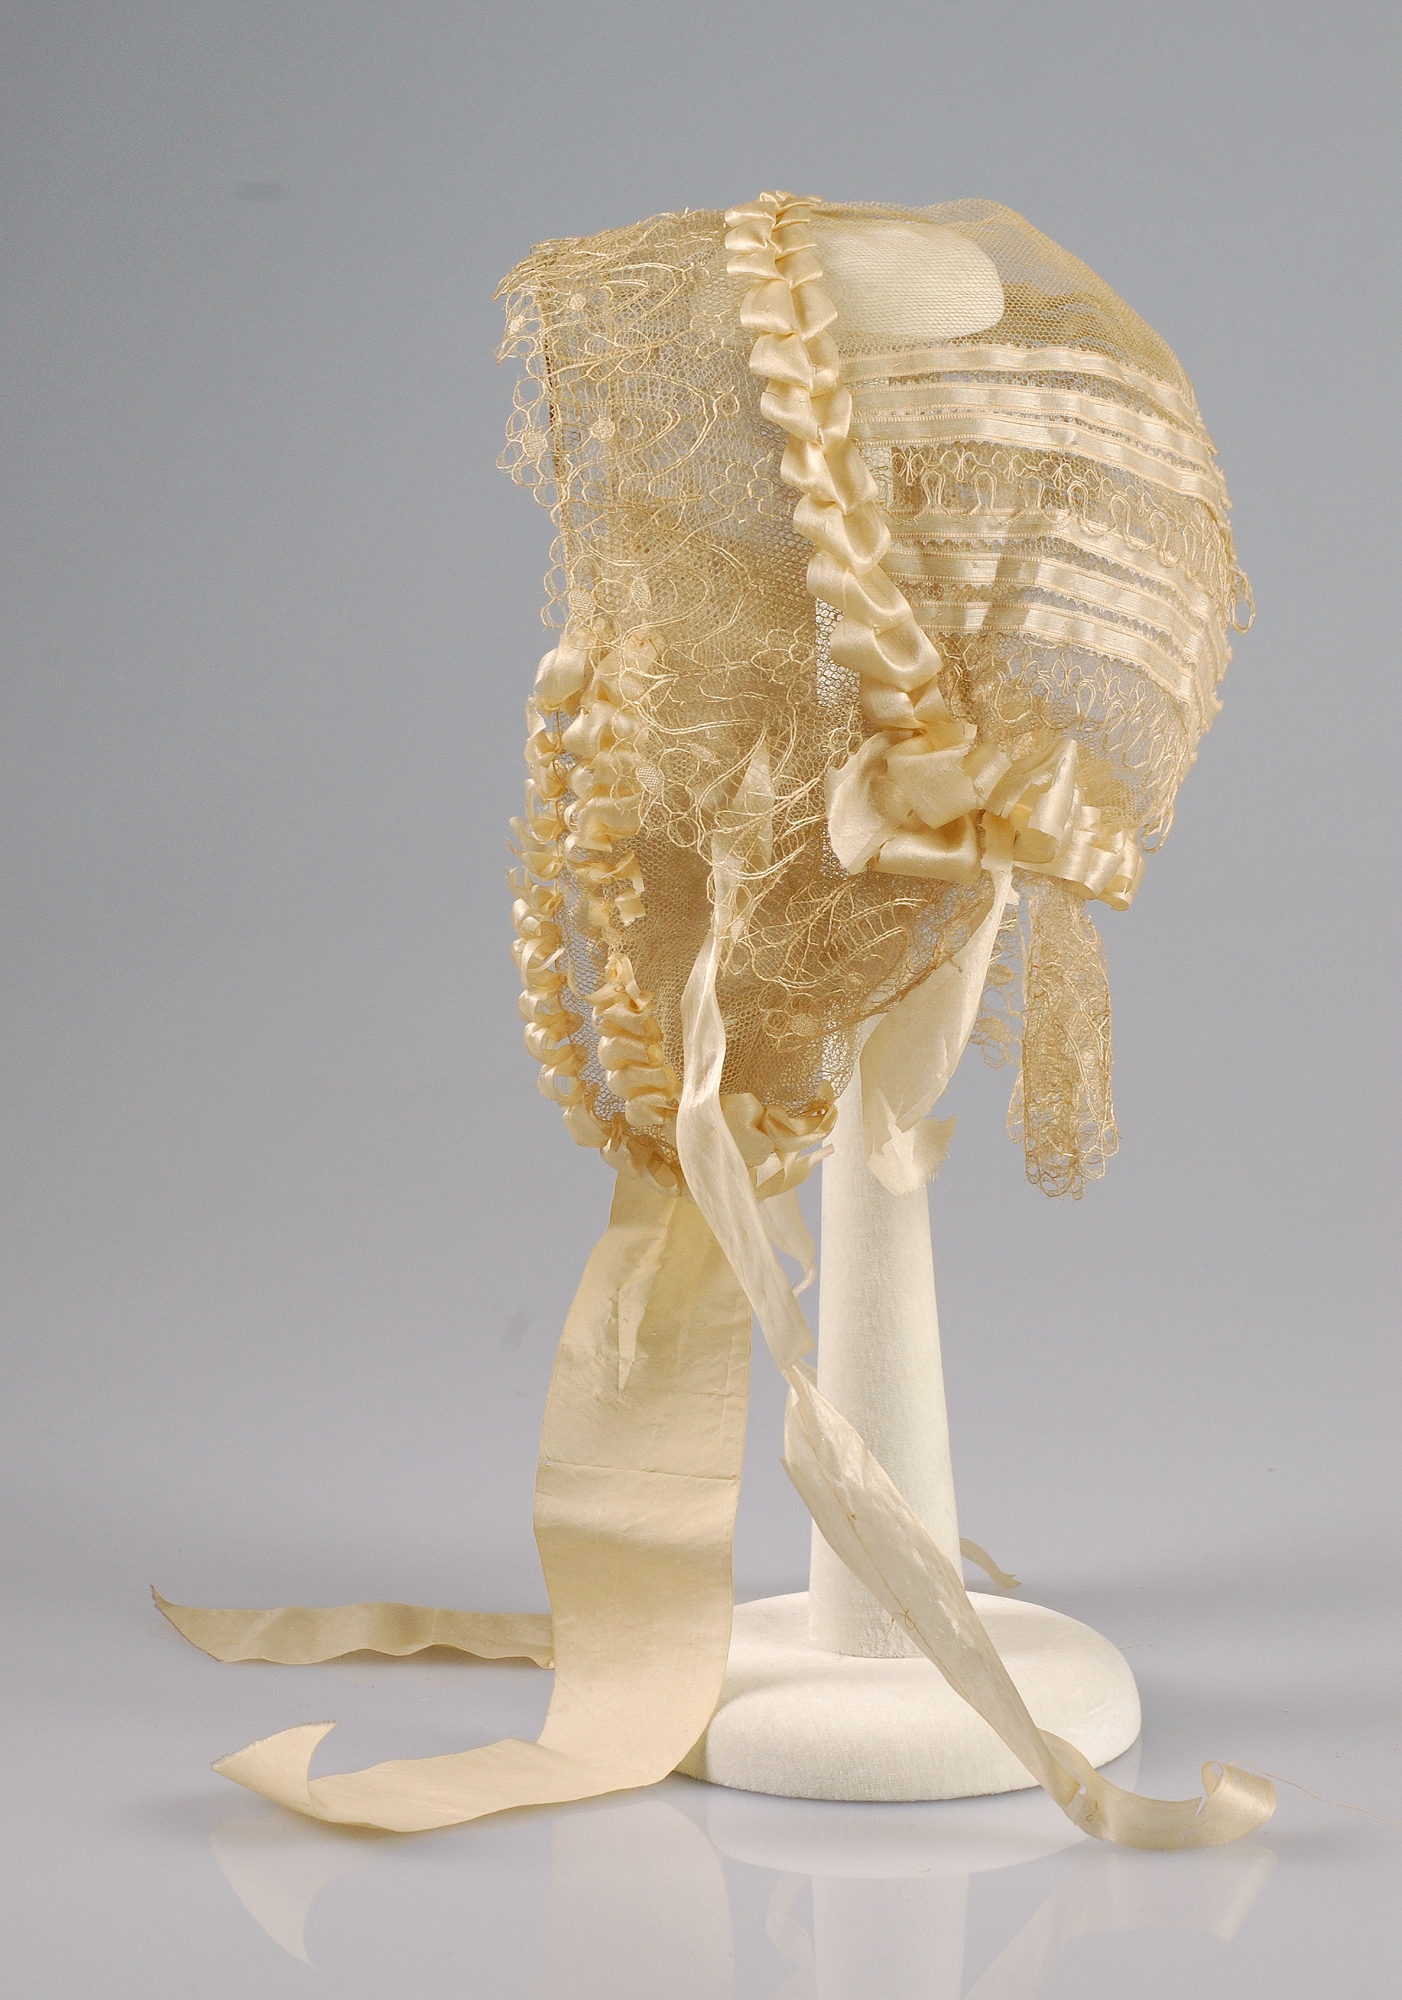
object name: cap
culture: american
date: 1854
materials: linen, silk